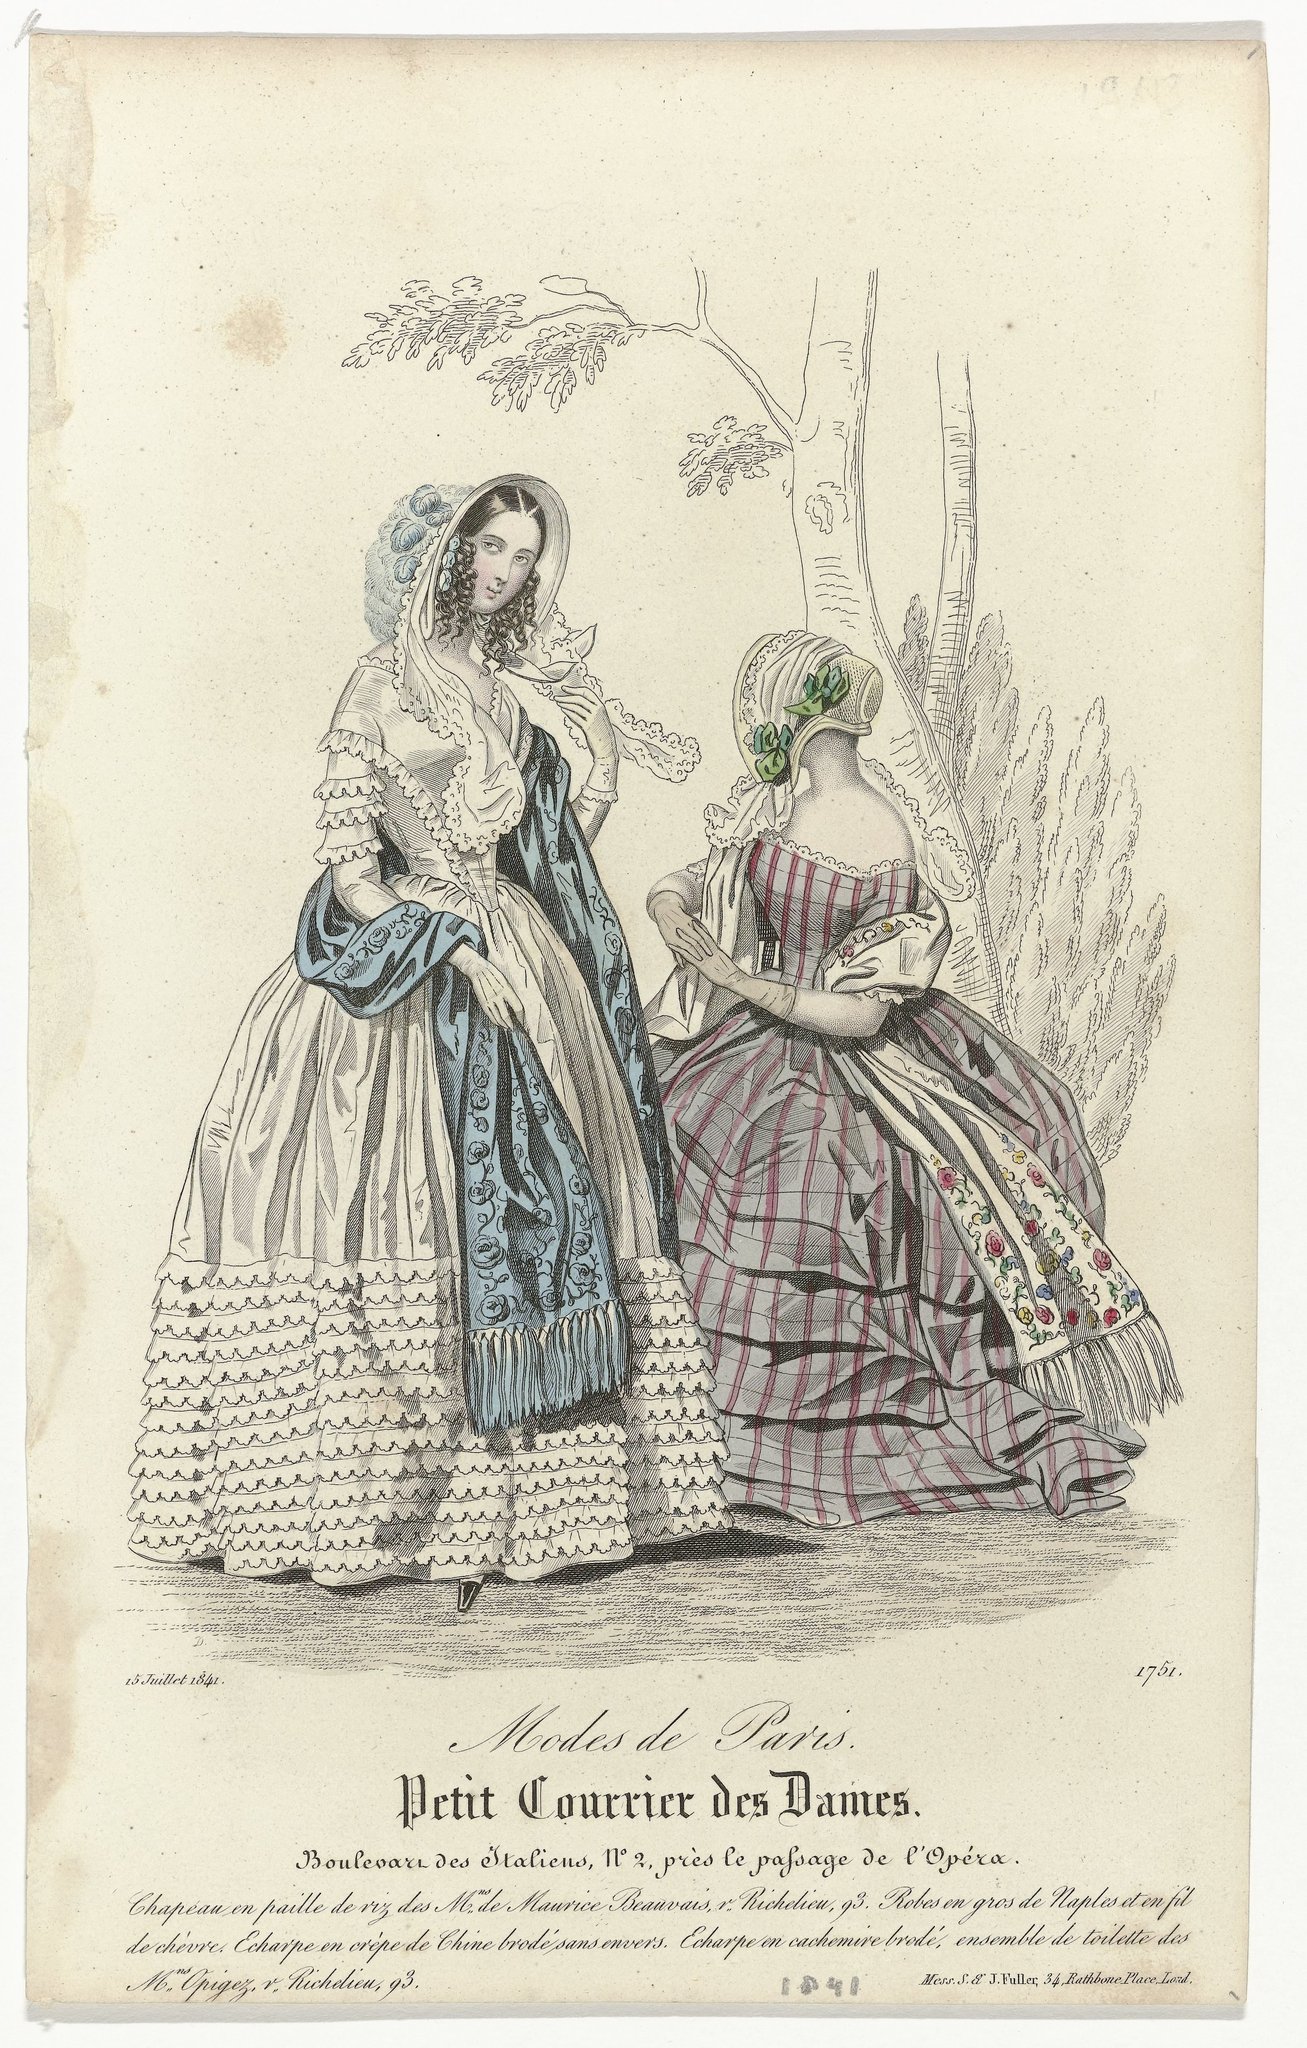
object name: fashion print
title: Petit Courrier des Dames, 15 juillet 1841, No. 1751 : Chapeau en paille de riz (...)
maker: Anonymous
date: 1841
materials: paper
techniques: engraving, hand coloring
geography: london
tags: clothing for the upper part of the body (shawl) (+ women's clothes), embroidery (ornamentation) (+ women's clothes), fashion plates, head-gear: hat (+ women's clothes), shoes, sandals (+ women's clothes), gloves, mittens, etc. (+ women's clothes), dress, gown (+ women's clothes)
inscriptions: caption: ‘Chapeau en paille de riz des M"ns de Maurice Beauvais, r"Richelieu, 93. Robes en gros de Naples et en fil de chèvre. Echarpe en crèpe de Chine brodé sans envers. Echarpe en cachemire brodé, ensemble de toilette des M"ns Opigez, r"Richelieu, 93.’, title: ‘Modes de Paris. / Petit Courrier des Dames.’, address: ‘Boulevart des Italiens, No 2, près le passage de l'Opéra. / Mess. S. & J. Fuller, 34, Rathbone Place, lond.’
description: Twee vrouwen bij een boom. Volgens het onderschrift: hoed van 'paille de riz' uit de winkels van Maurice Beauvais. Japonnen van 'gros de Naples' en 'en fil de chèvre'. Sjaal van 'crèpe de Chine brodé sans envers.' Sjaal van geborduurde kasjmier. 'Ensemble de toilette' uit de winkels van Opigez. Prent uit het modetijdschrift Petit Courrier des Dames (1821-1868).